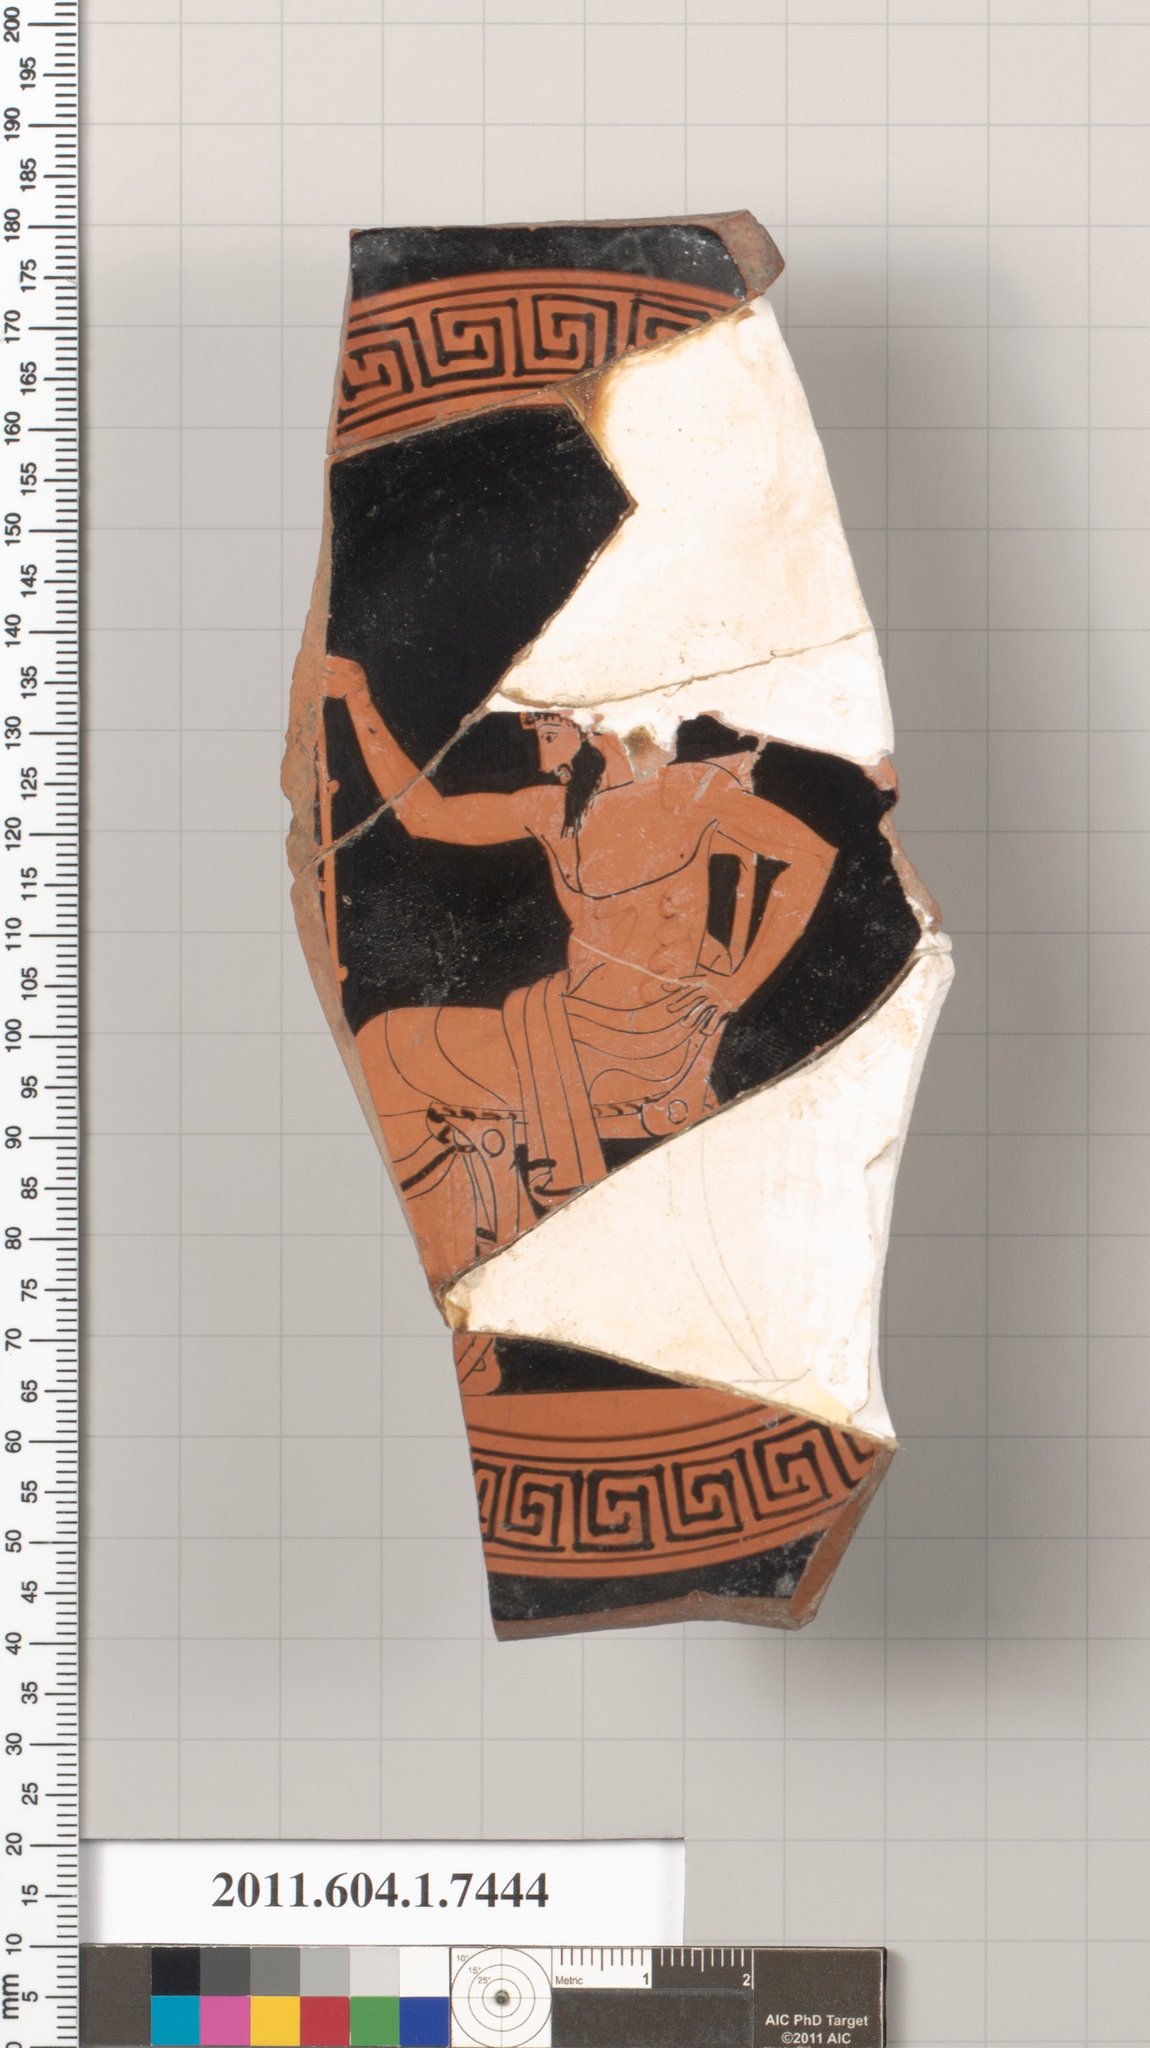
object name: kylix fragment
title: Terracotta fragment of a kylix (drinking cup)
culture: greek, attic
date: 490-470 BCE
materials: terracotta